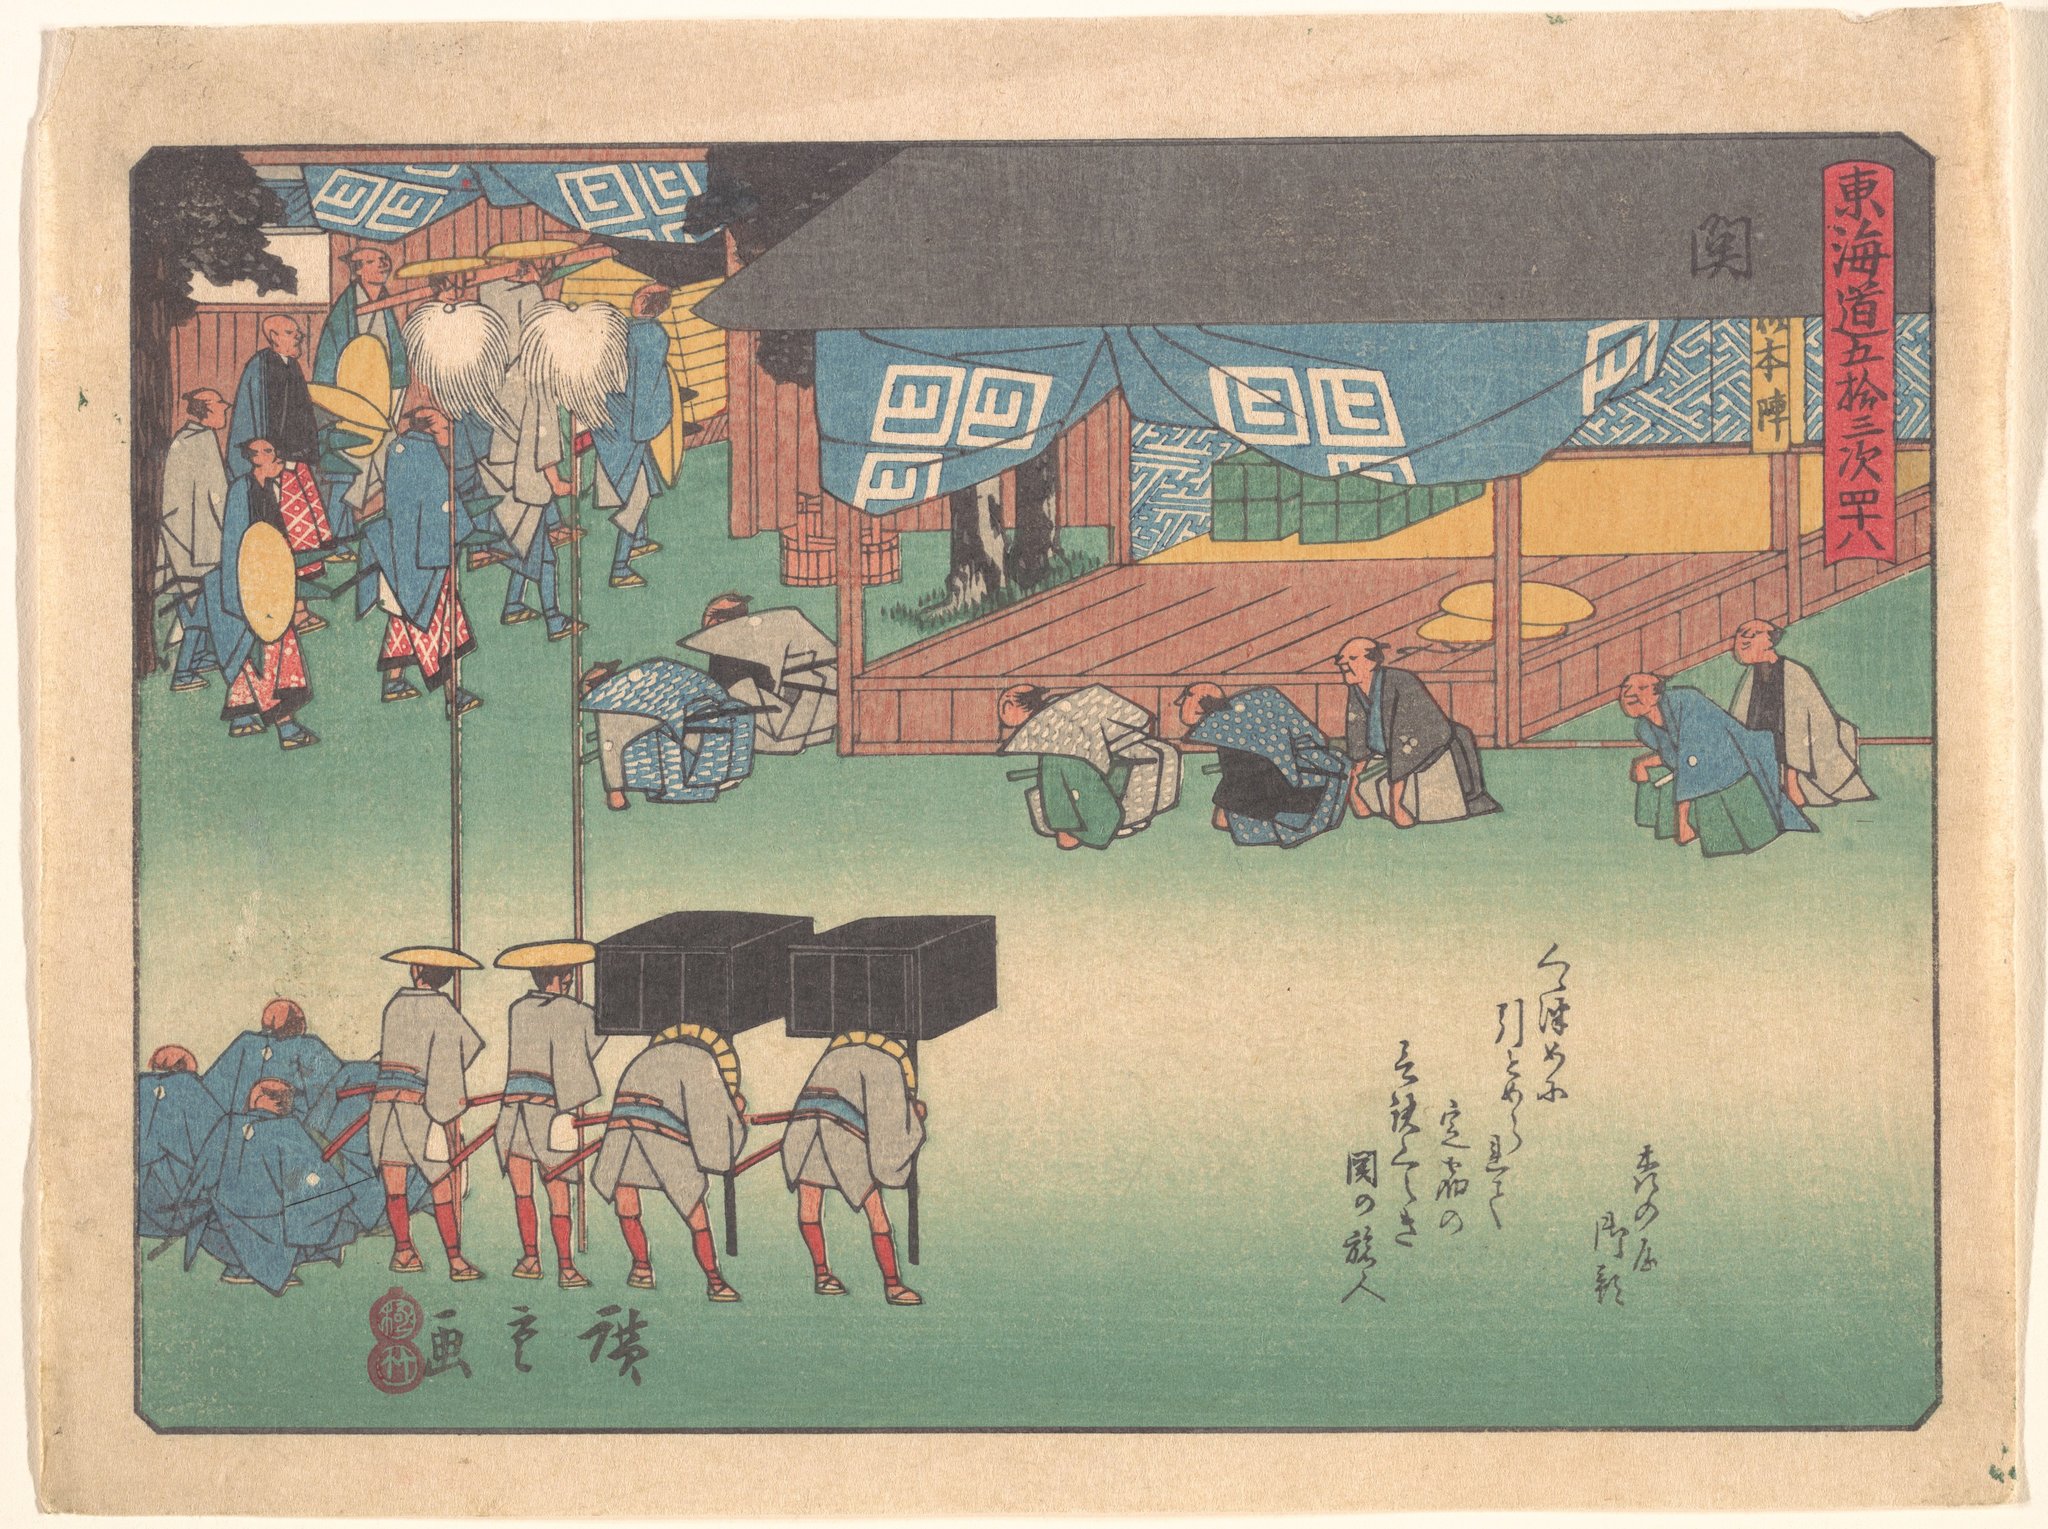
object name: print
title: Seki, from the series The Fifty-three Stations of the Tōkaidō Road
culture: japanese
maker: utagawa hiroshige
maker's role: artist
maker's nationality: japanese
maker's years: 1797-1858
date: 1901-1933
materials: ink, paper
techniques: woodblock print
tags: men